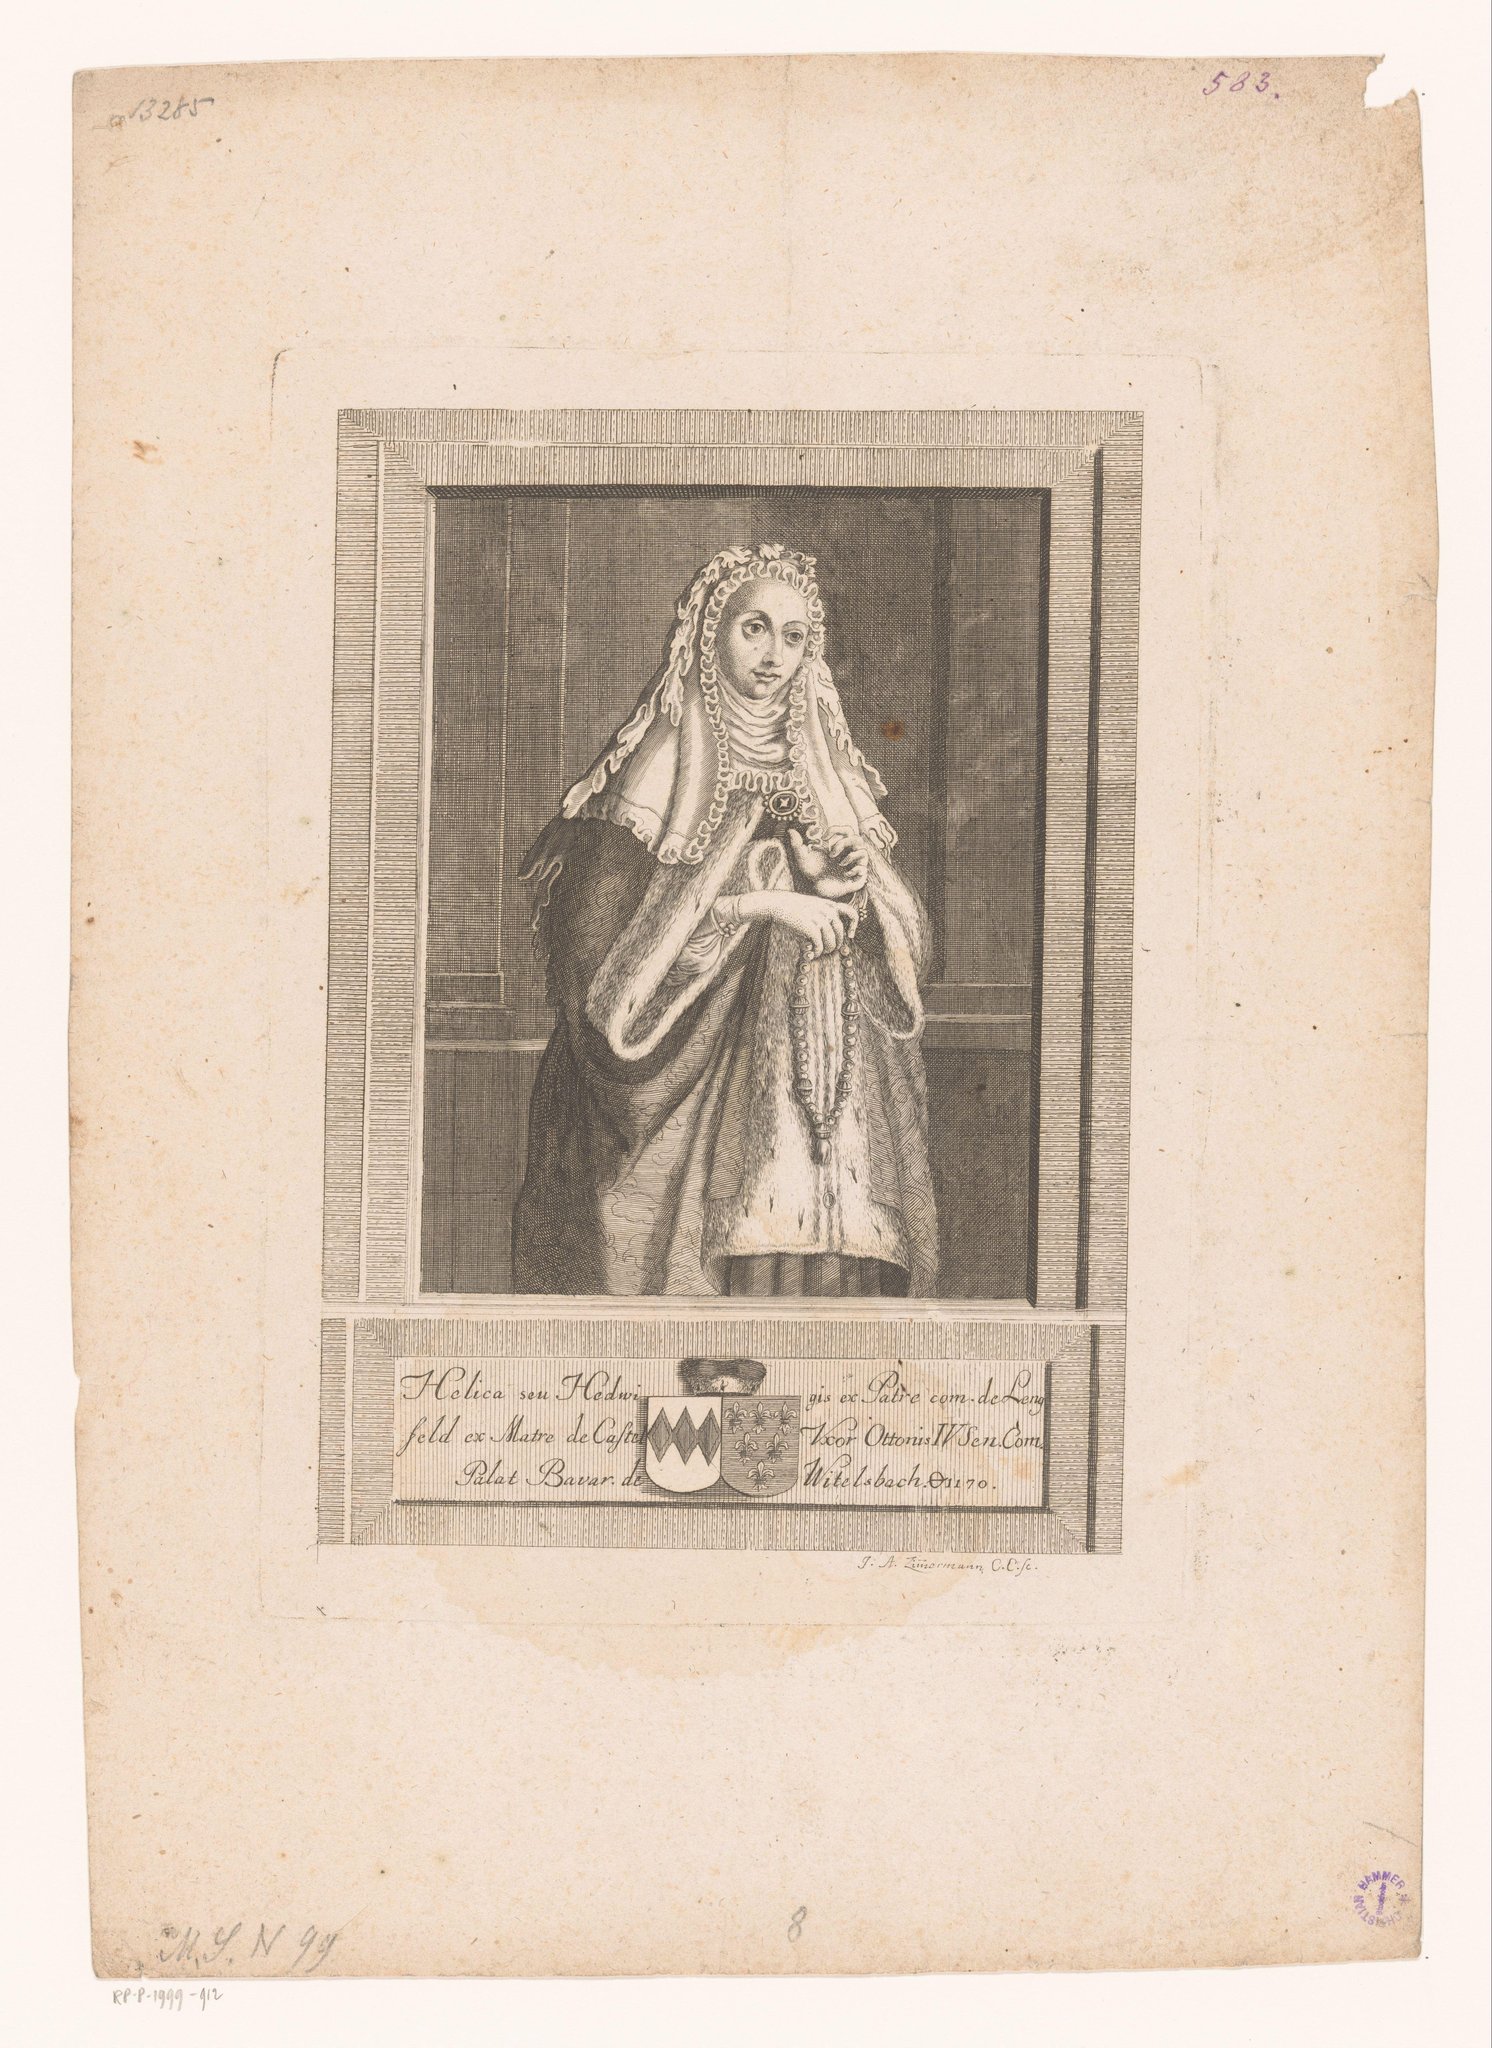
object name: print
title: Portret van Heilika von Lengenfeld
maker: joseph anton zimmermann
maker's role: draughtsman, print maker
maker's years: 1705-1797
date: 1773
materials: paper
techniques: engraving, etching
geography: germany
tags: historical persons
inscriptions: collector's mark: Lugt 1238, collector's mark: Lugt 2760, collector's mark: Lugt 2228, collector's mark: Lugt 4100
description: Prent gebruikt voor de publicatie: Zimmermann, Joseph Anton. Series Imaginum Augustae Domus Boicae. München: s.n., 1773.